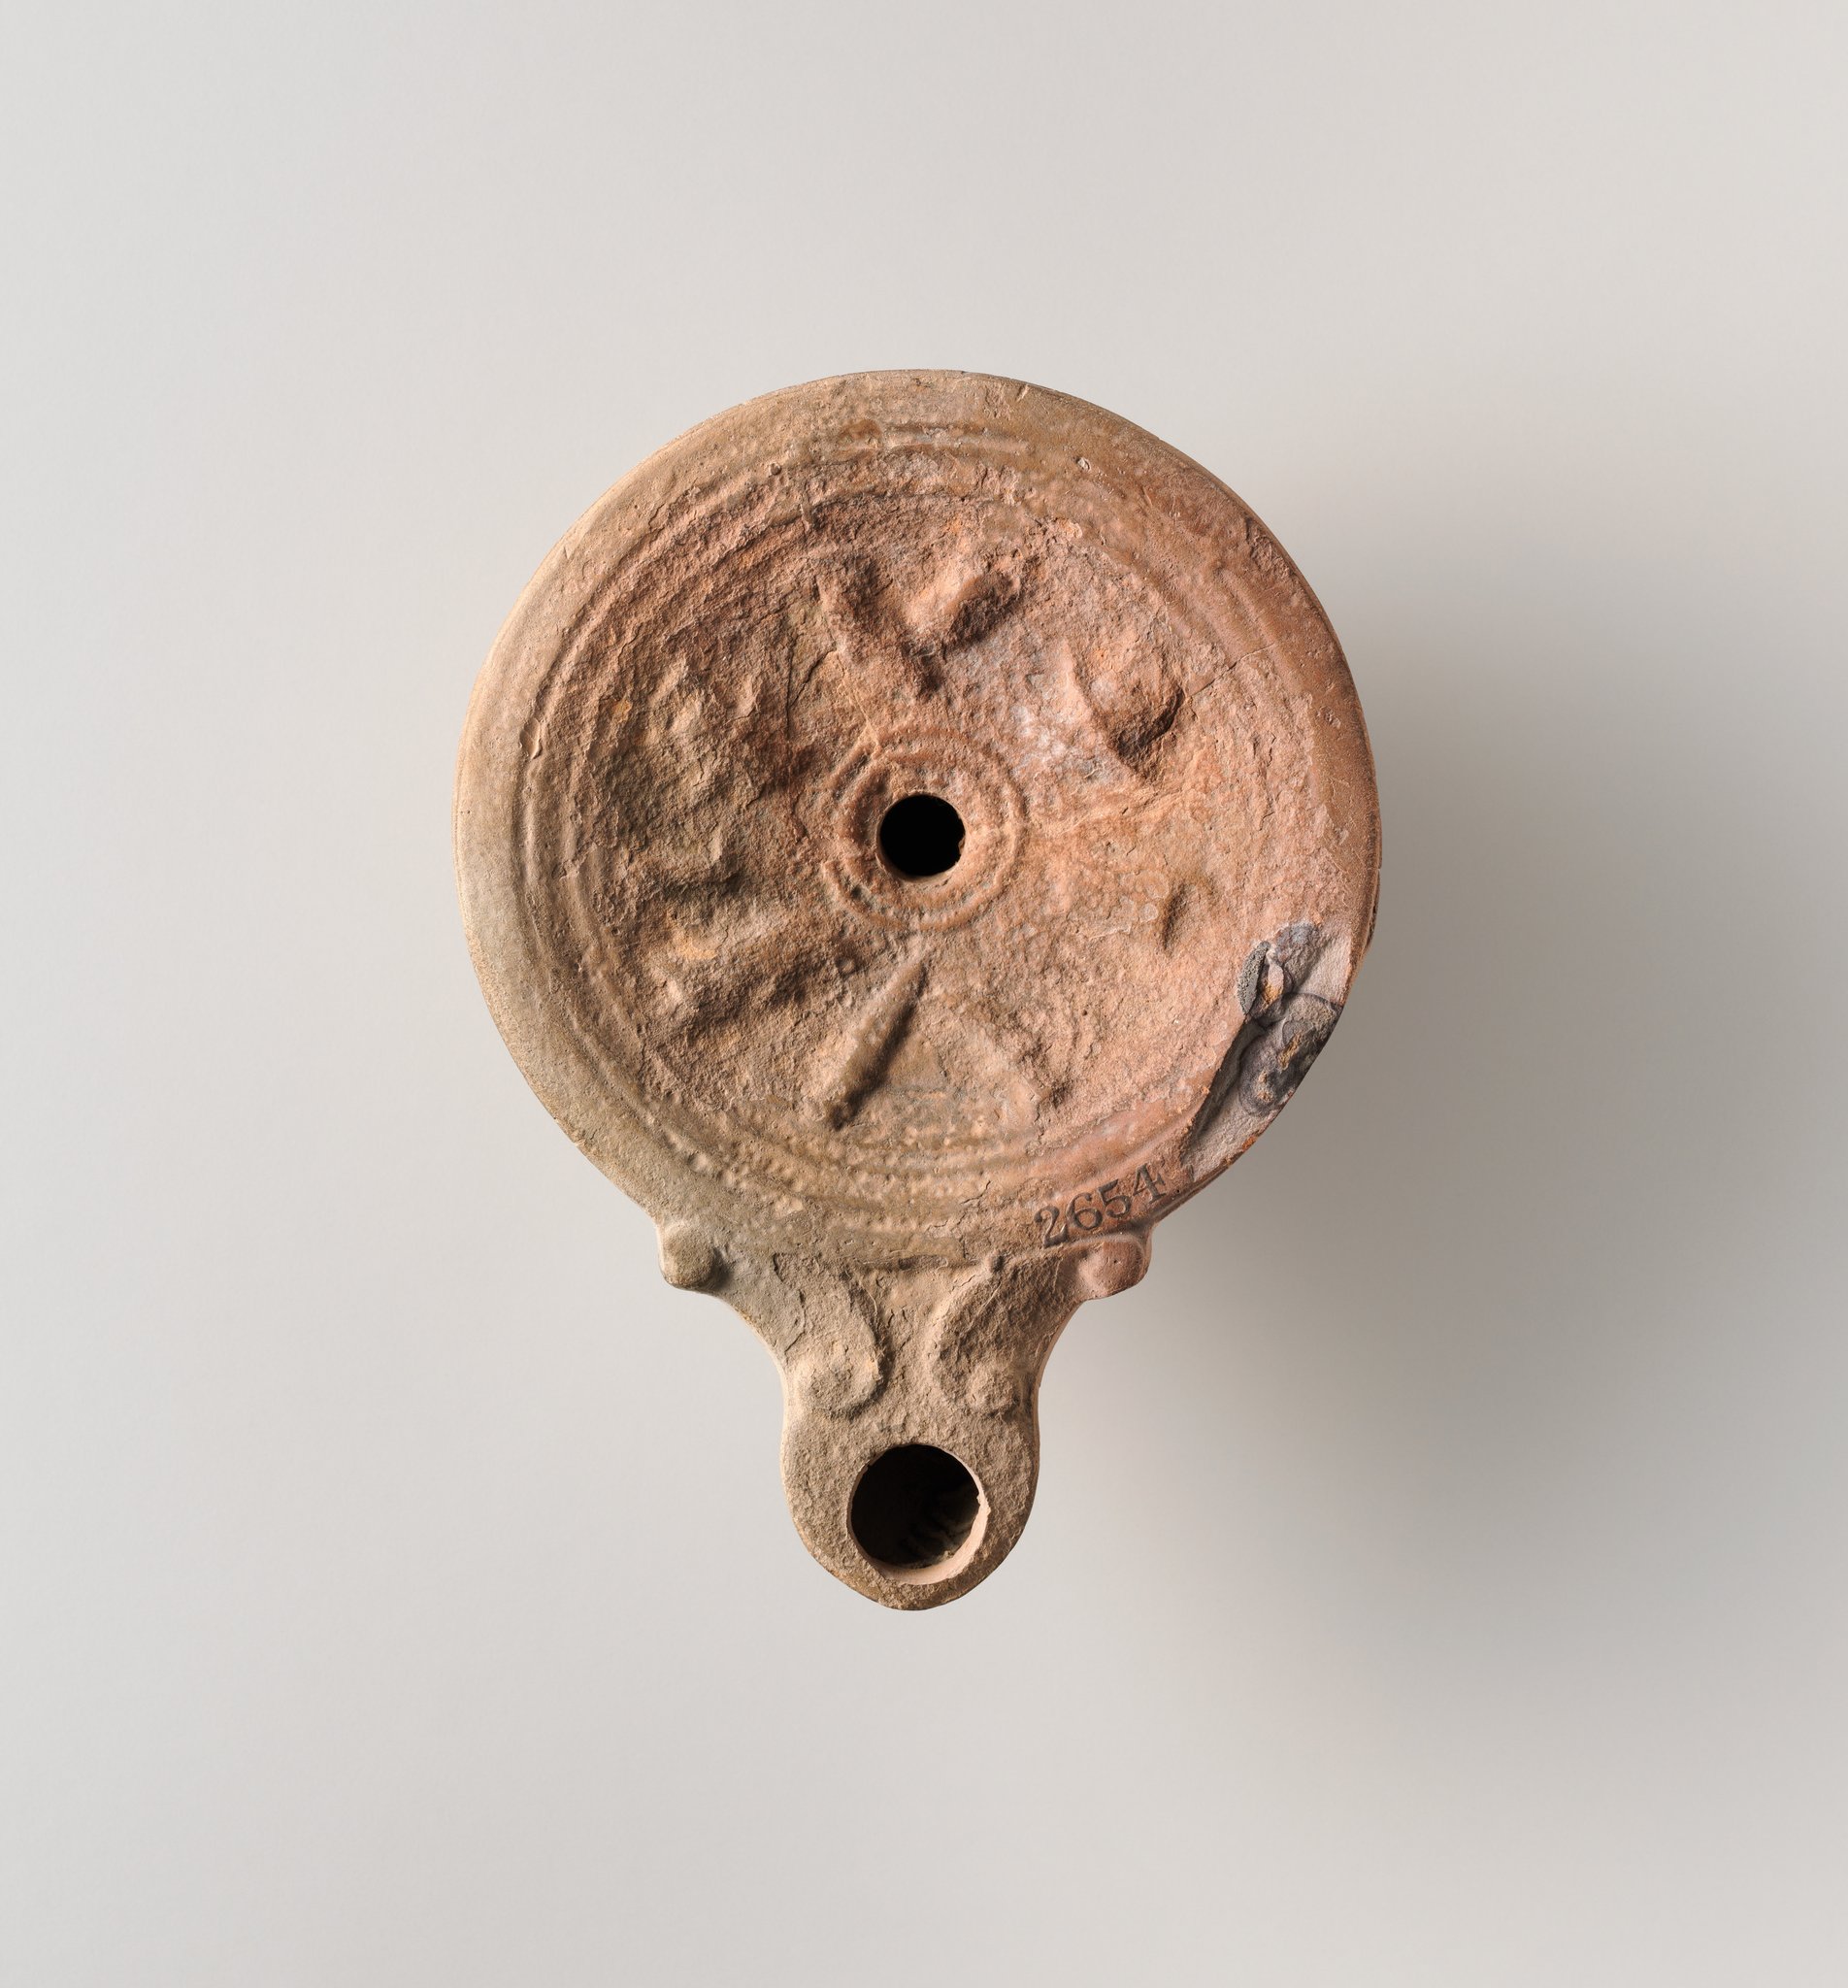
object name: lamp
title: Terracotta oil lamp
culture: roman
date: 100 BCE-100 CE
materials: terracotta